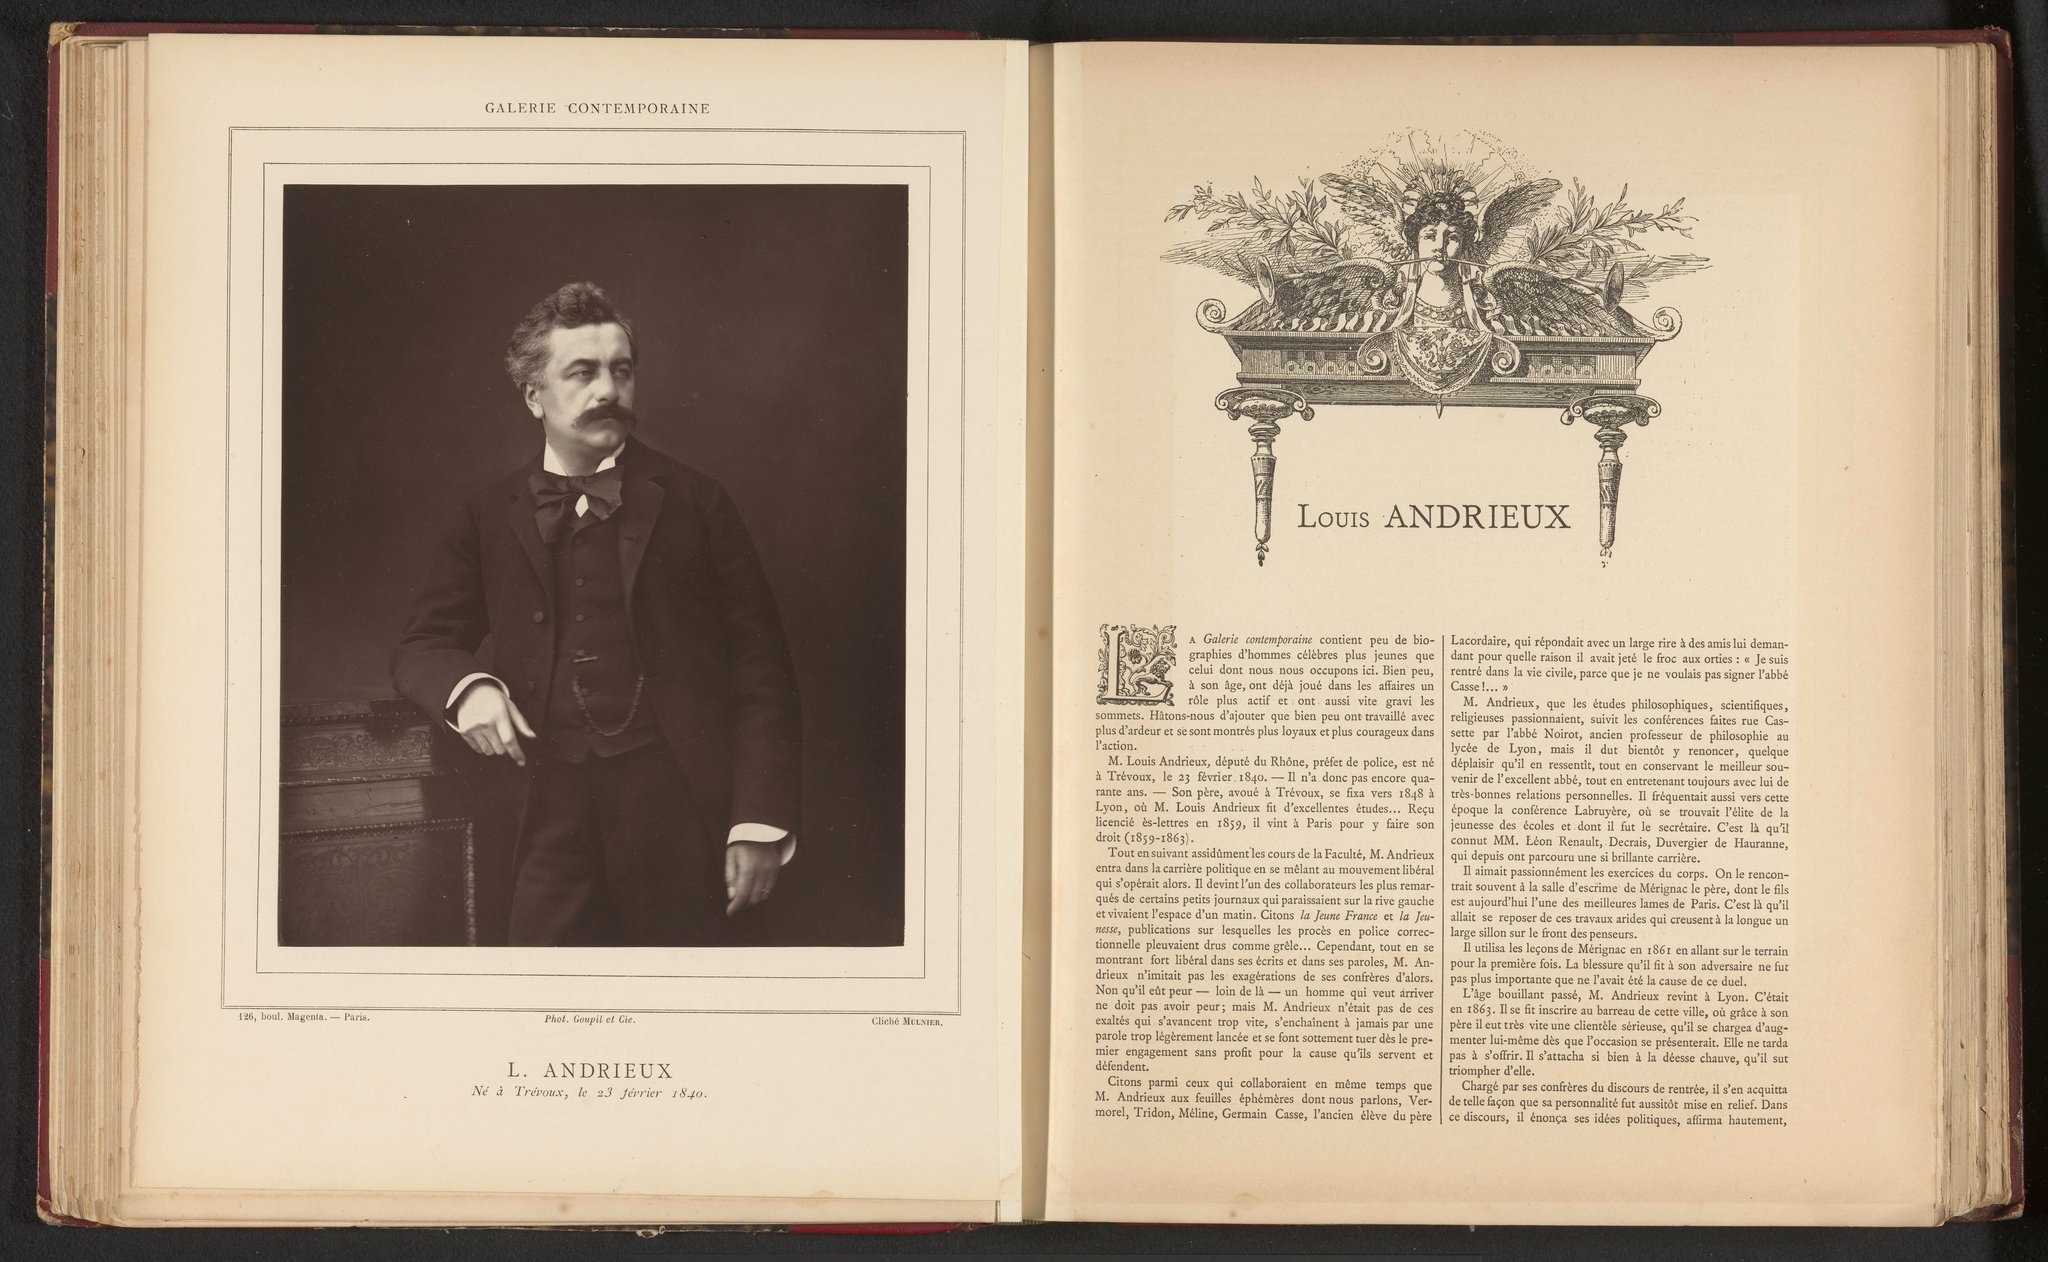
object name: page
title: Portret van Louis Andrieux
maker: ferdinand mulnier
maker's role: painter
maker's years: 1817-1891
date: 1876-1879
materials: paper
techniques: woodburytype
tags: politician, politician, e.g. party leader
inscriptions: inscription: ‘126, boul. Magenta.-Paris.’